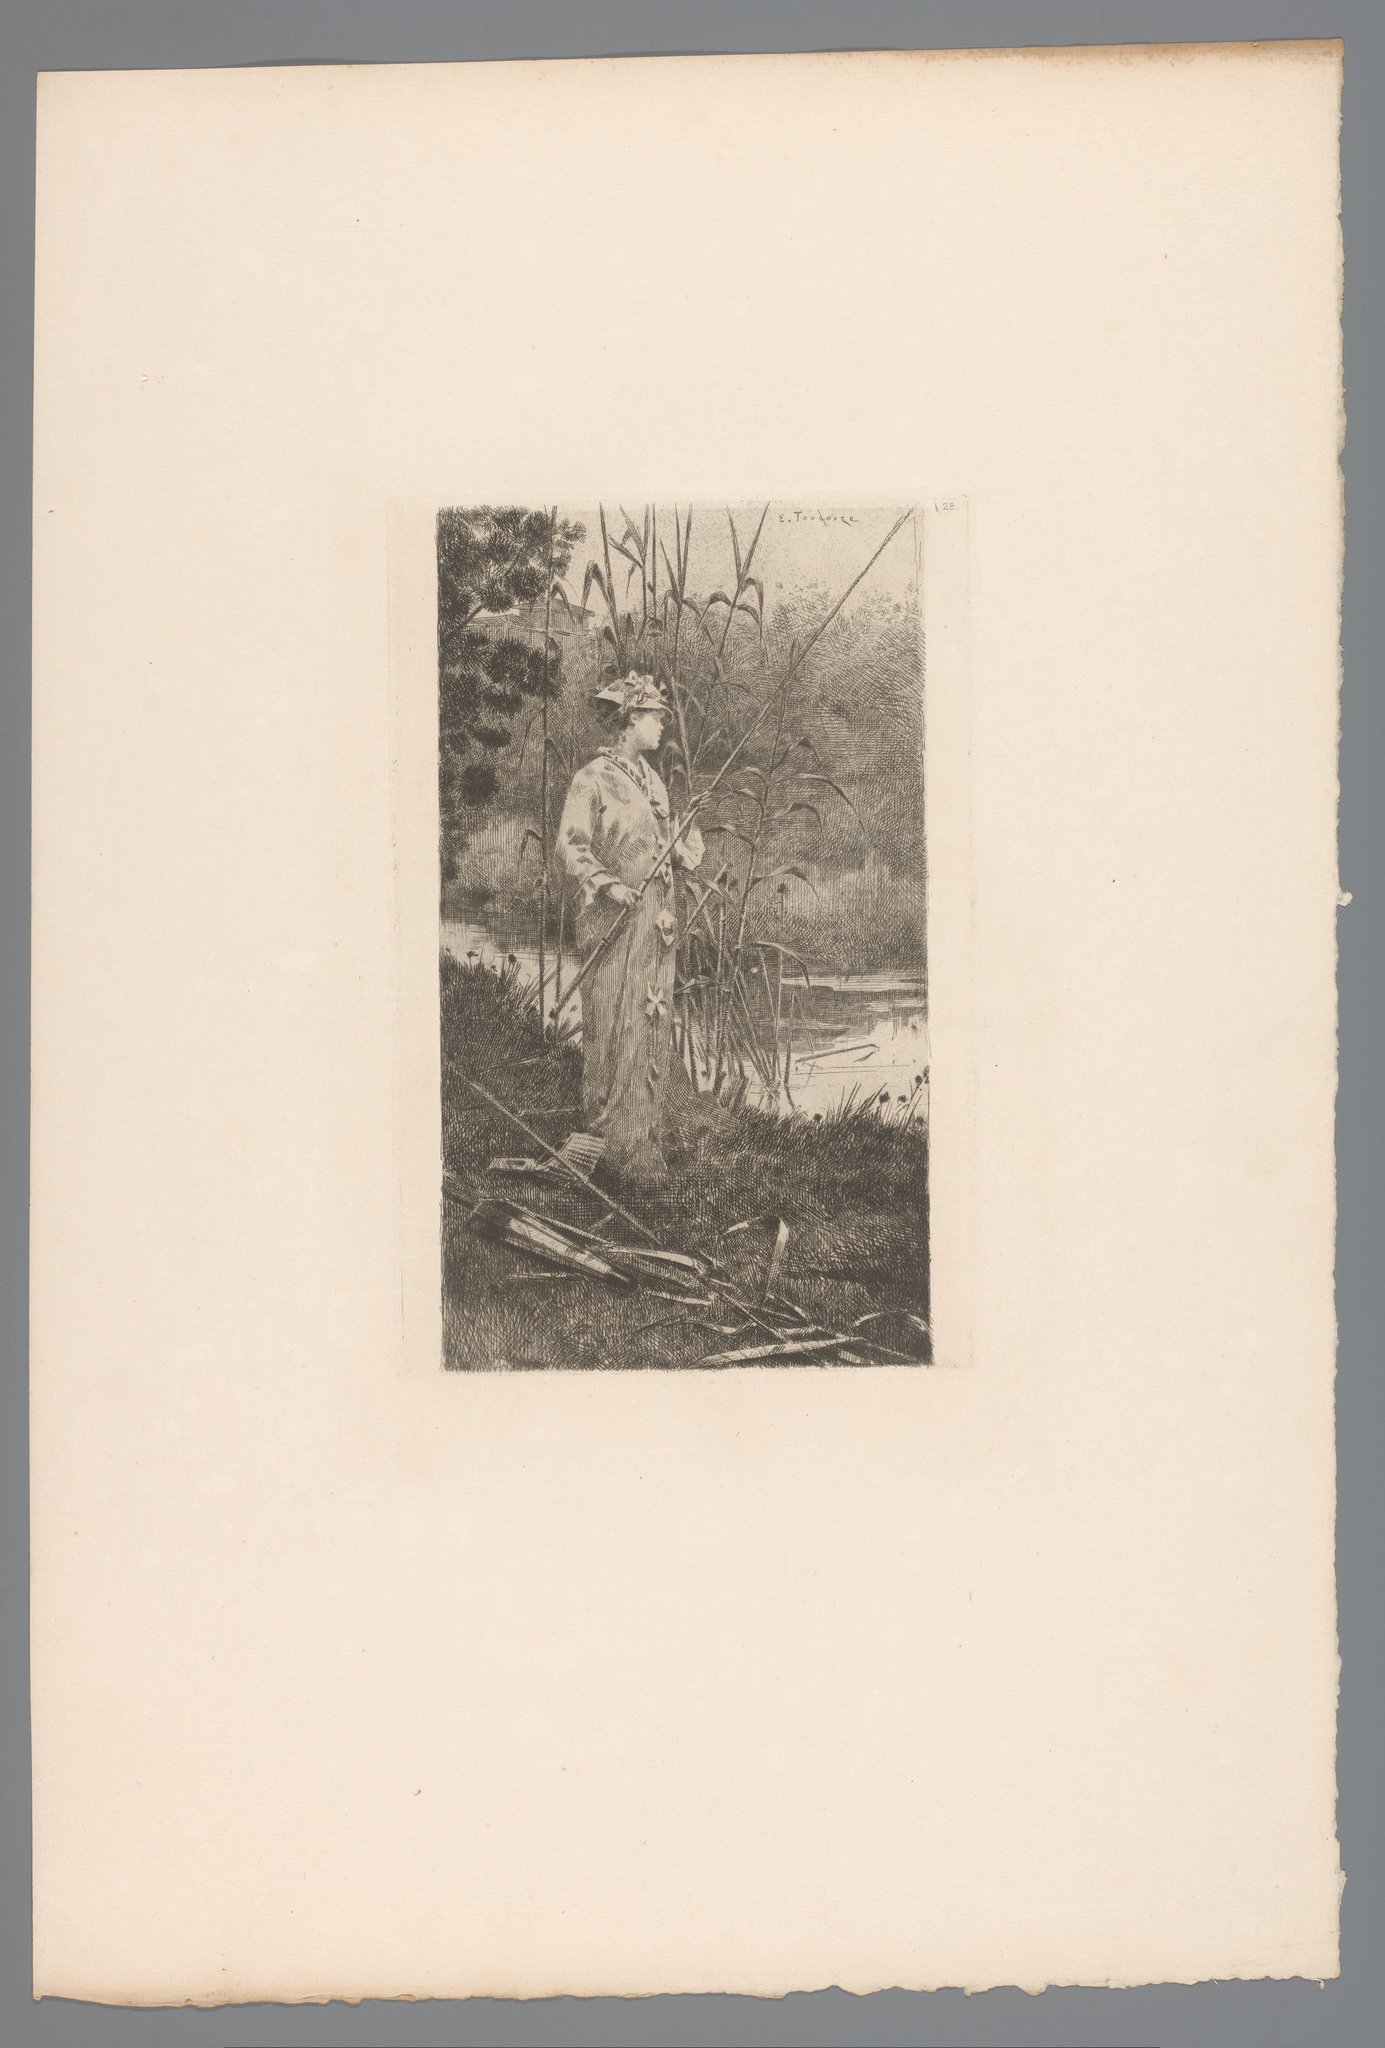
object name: print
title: Franse etsen uit 1881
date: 1881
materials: paper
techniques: drypoint, etching, intaglio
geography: paris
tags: angling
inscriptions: collector's mark: ‘AFE v S’, collector's mark: Lugt 2760, collector's mark: Lugt 2228